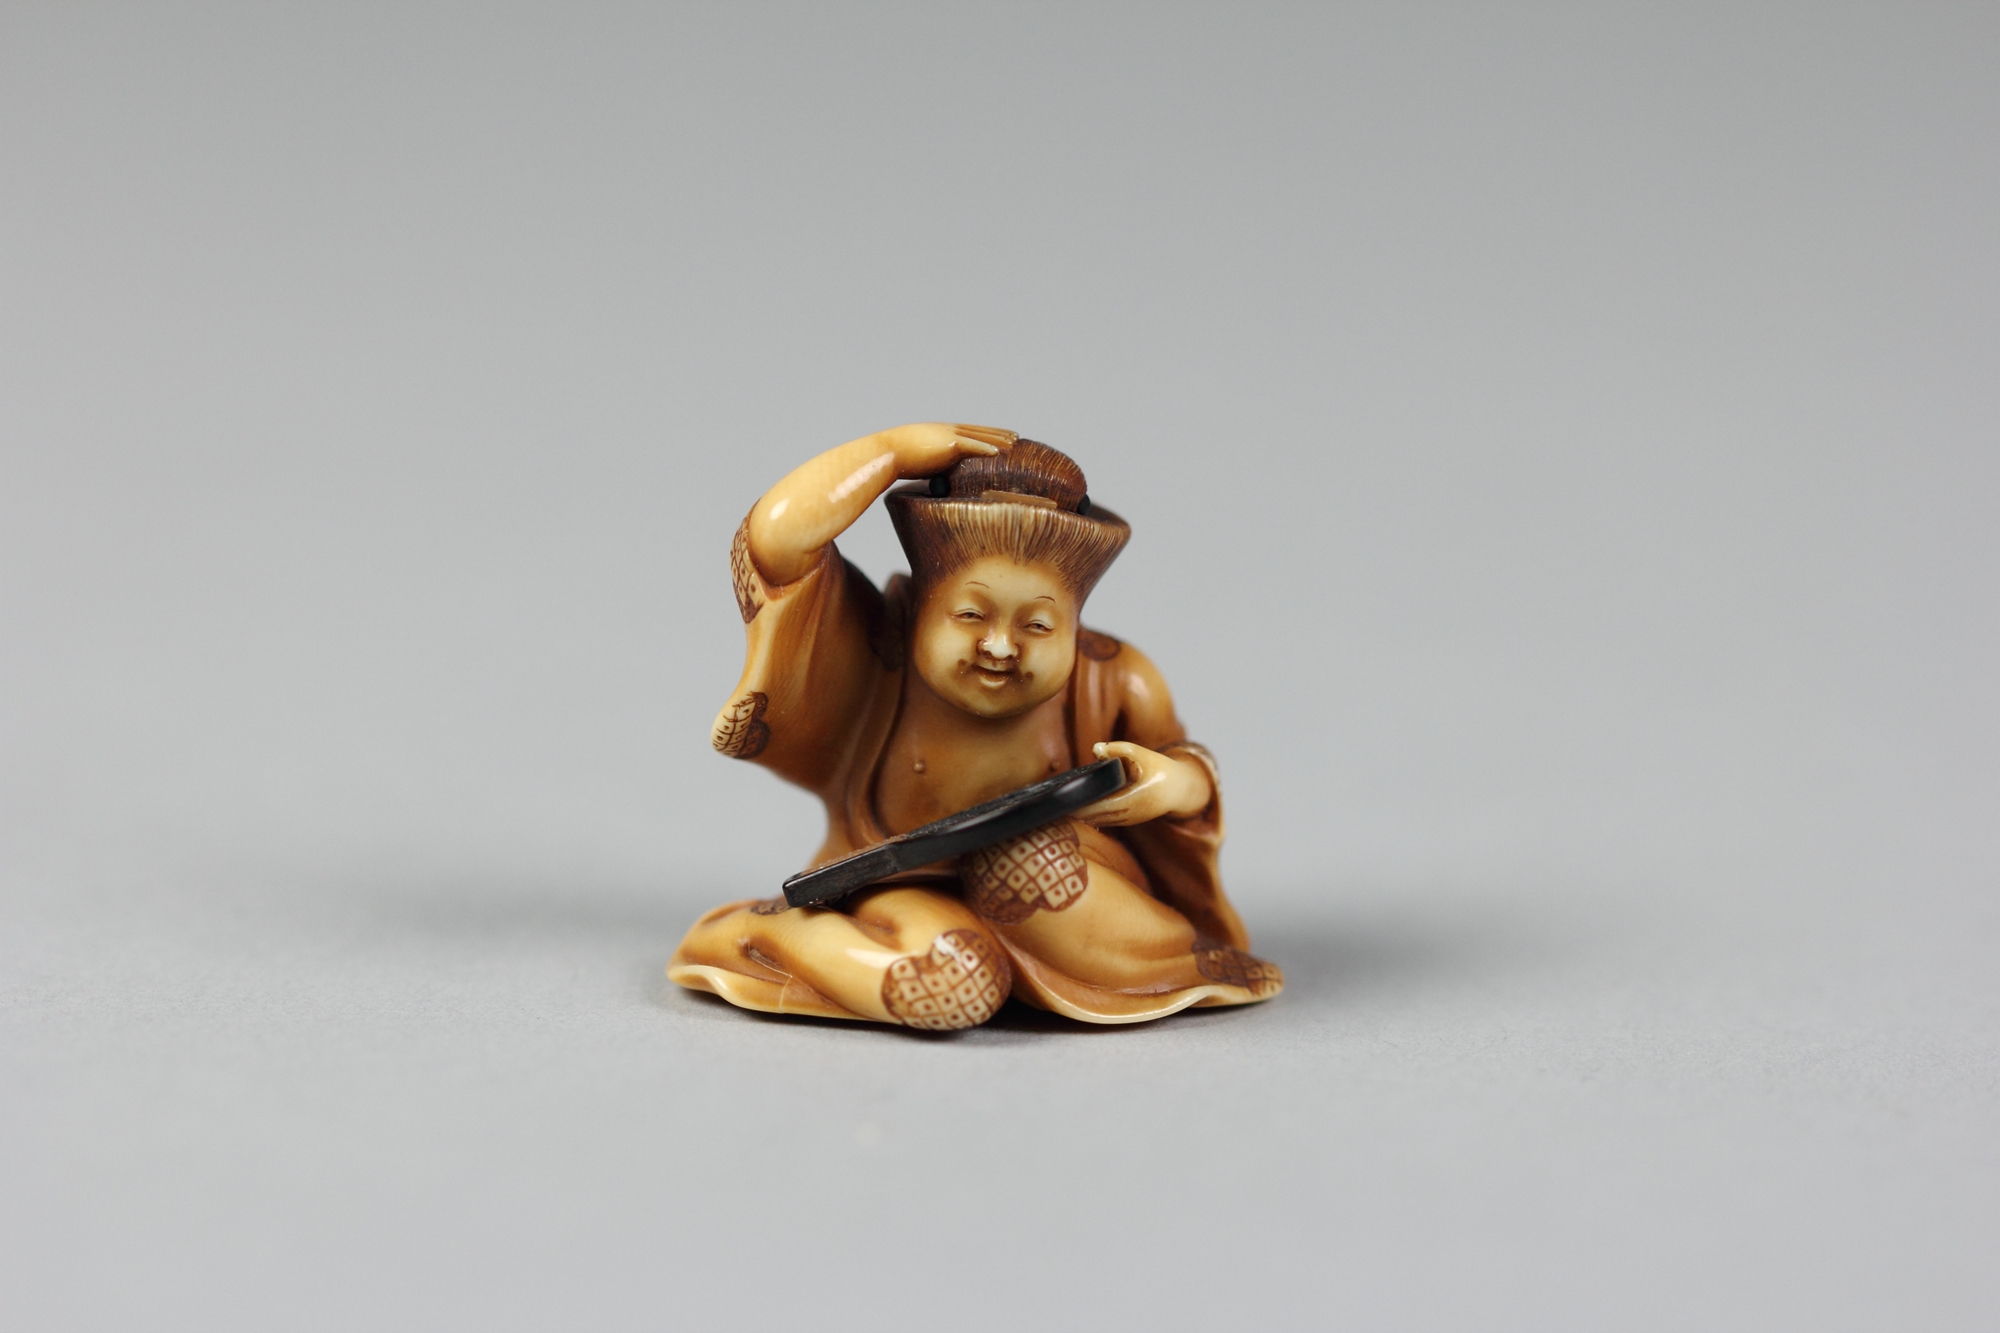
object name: netsuke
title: Netsuke of Girl at her Toilet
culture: japanese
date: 1801-1900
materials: ivory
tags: girls